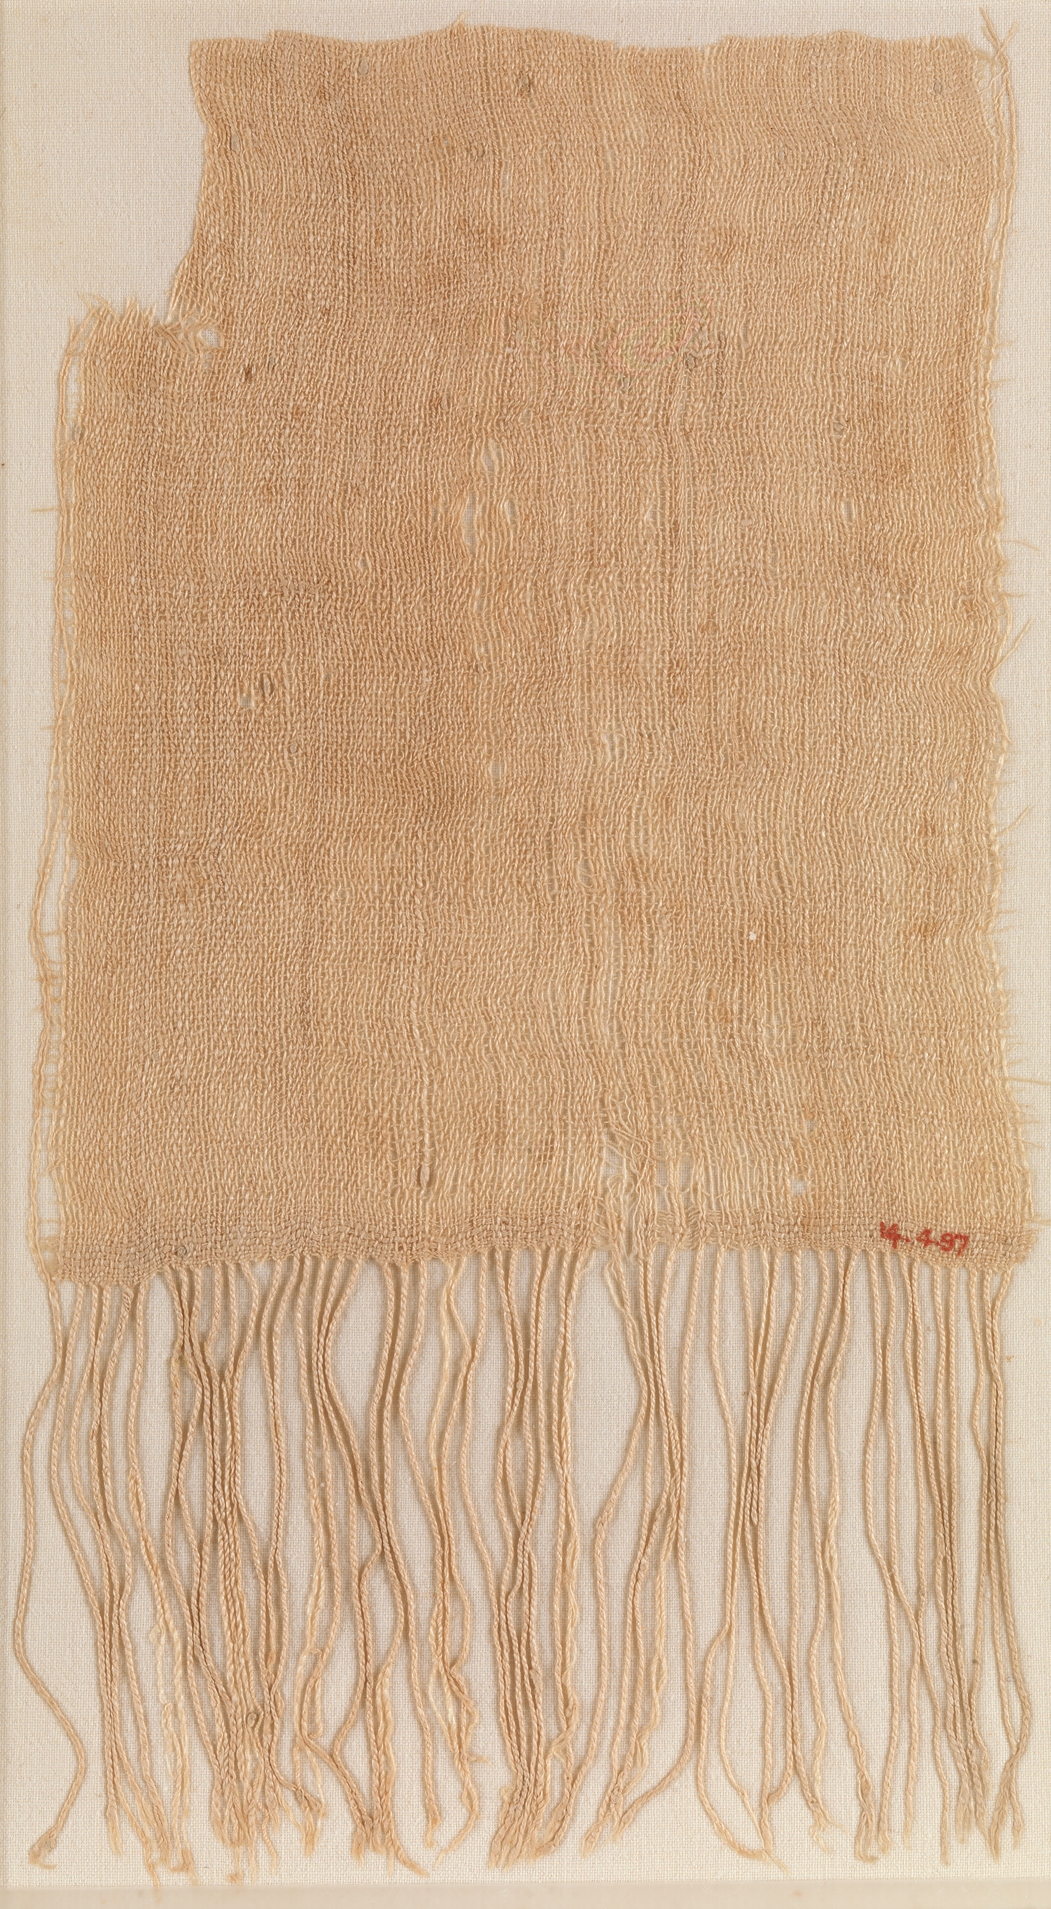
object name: linen fragment, fringe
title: Sample of Fringed Cloth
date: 818-700 BCE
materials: linen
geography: egypt